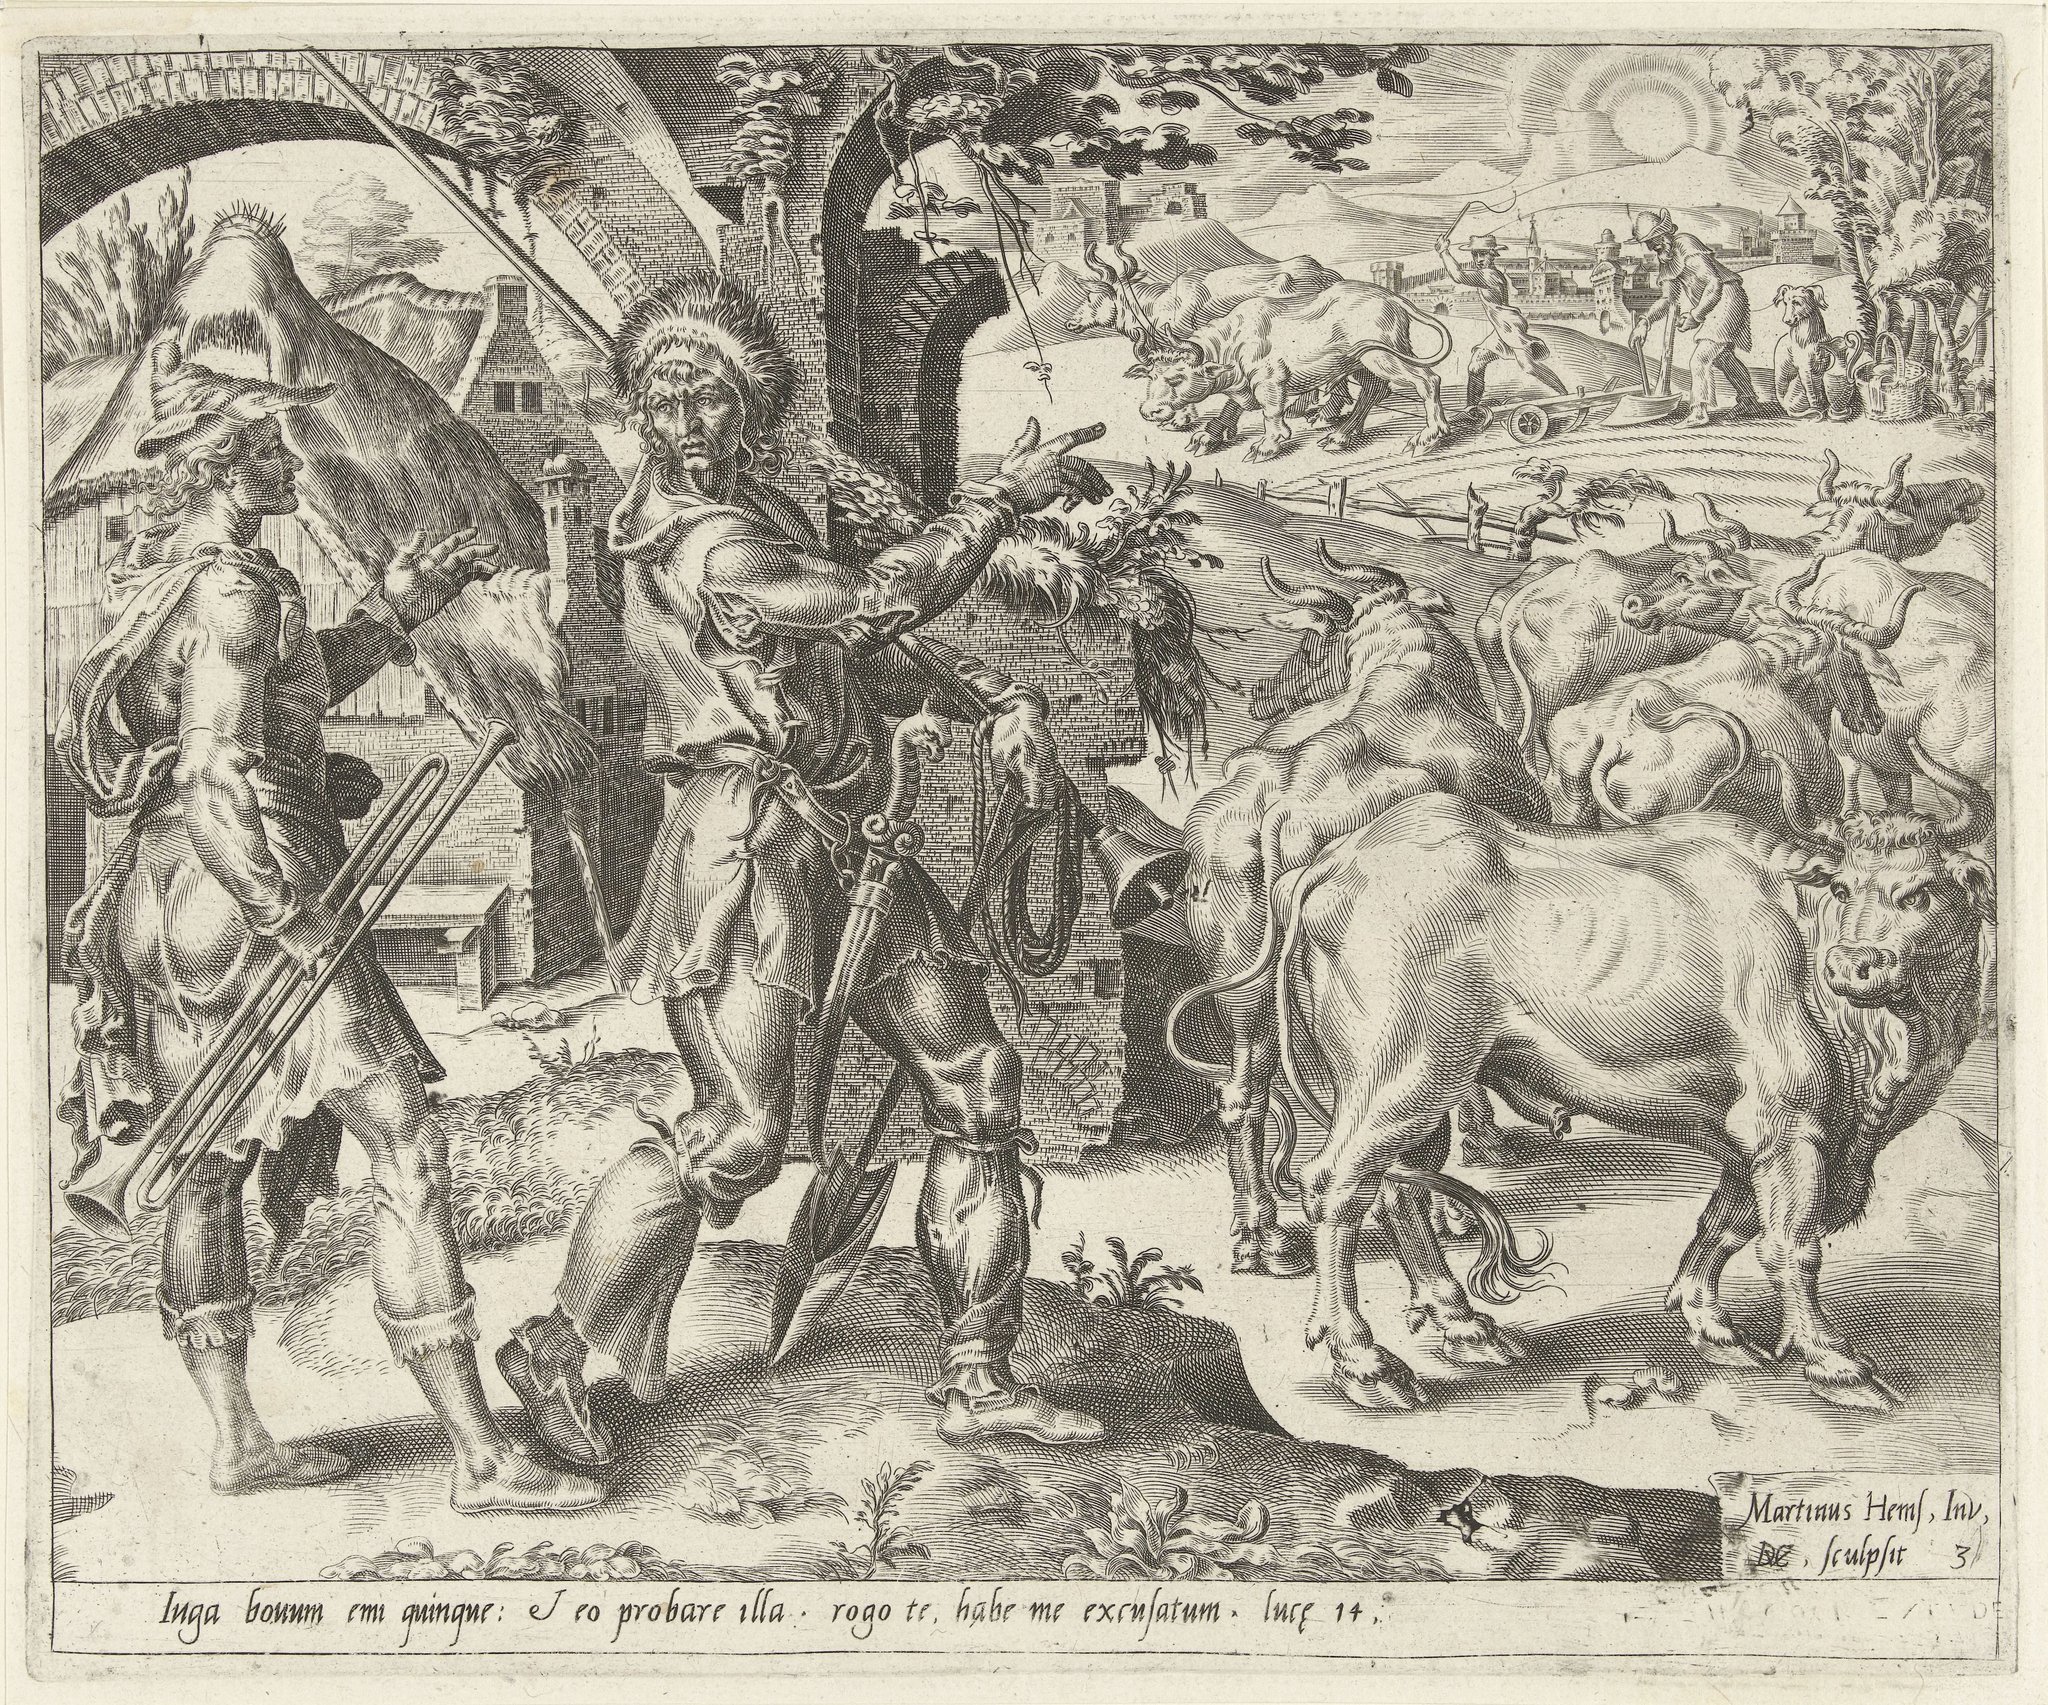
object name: print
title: Gelijkenis van een bruiloftsfeest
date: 1558-1559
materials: paper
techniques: engraving, etching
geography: haarlem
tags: those that are invited to the royal wedding-feast excuse themselves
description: De boodschapper van de koning komt bij de tweede gast en nodigt hem uit voor het bruiloftsfeest. De gast verontschuldigt zich met het voorwendsel dat hij een nieuwe kudde vee heeft gekocht. De man wijst naar de kudde op de achtergrond. De prent heeft een Latijns onderschrift en maakt deel uit van een zesdelige serie over de gelijkenis van een bruiloftsfeest.